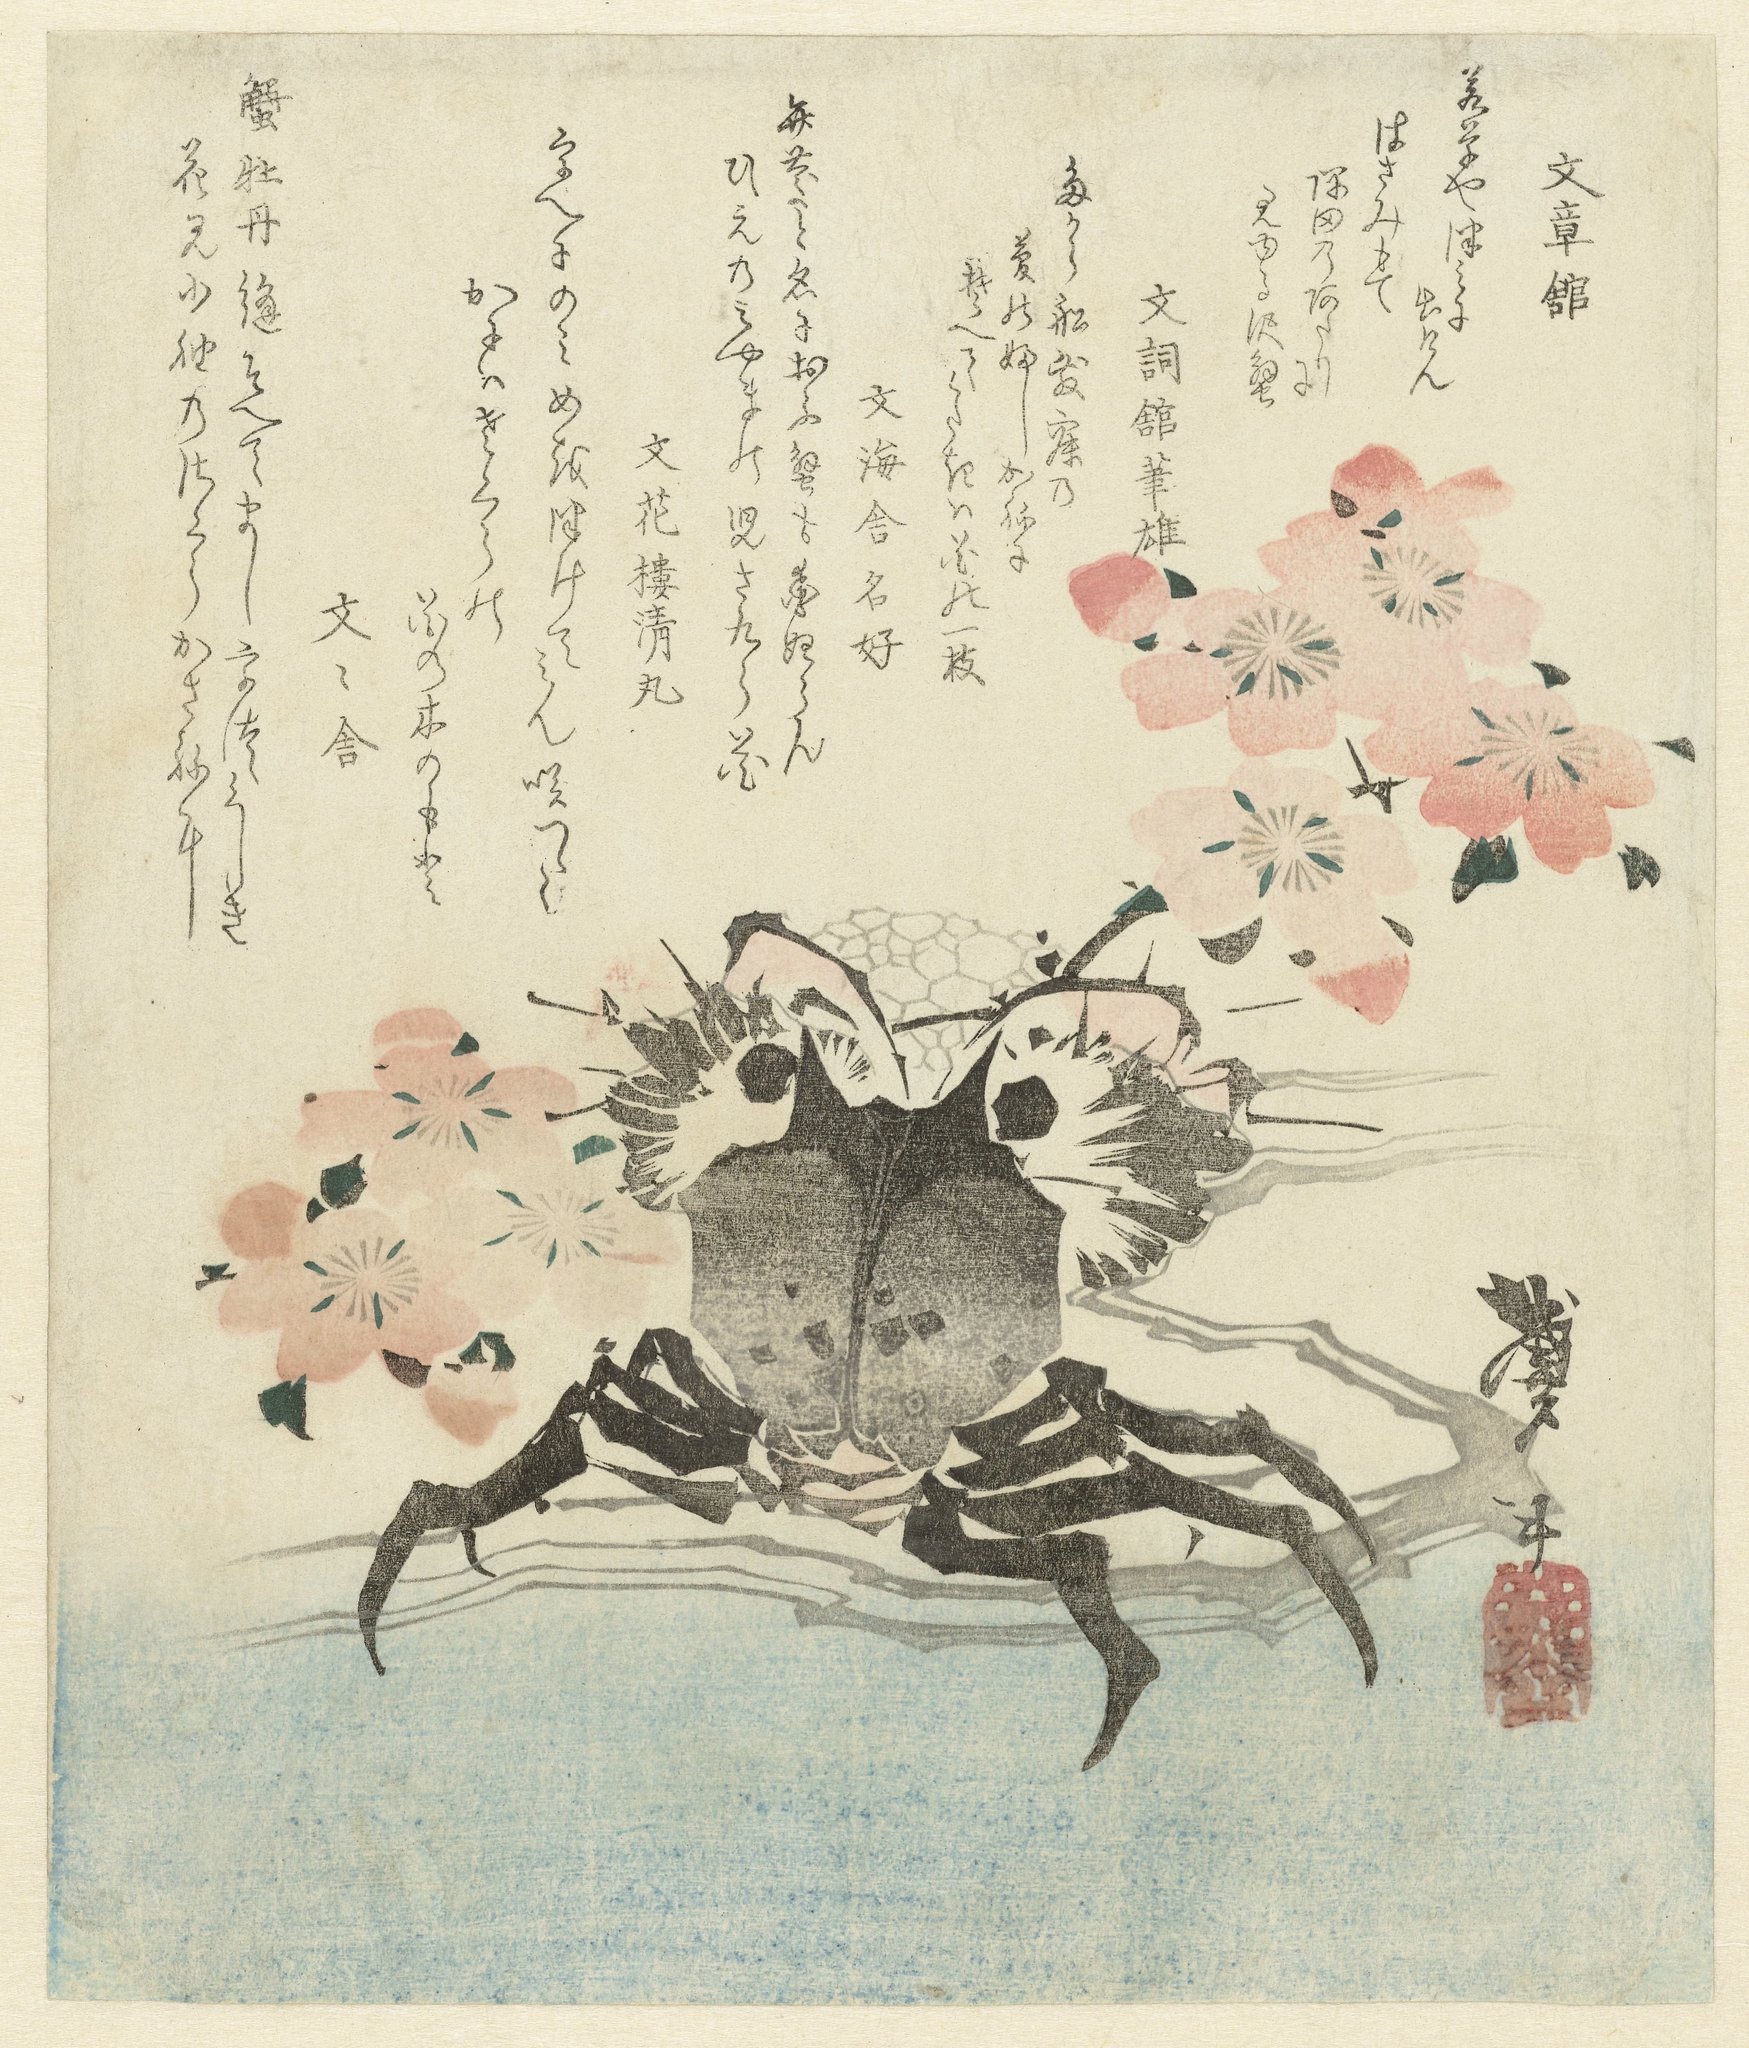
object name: surimono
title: Krab met kersenbloesem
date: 1825-1830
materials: paper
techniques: blind stamped, woodcut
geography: japan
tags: plants; vegetation (+ flowers, blossom, blossoming), crustaceans: crab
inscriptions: collector's mark, verso, stamped: Lugt 2228, collector's mark, verso, stamped: Lugt 2760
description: Een surimono is een luxe uitgevoerde prent waarop beeld met één of meerdere gedichten gecombineerd is. Bij het drukken van een surimono werd vaak gebruik gemaakt van dikker papier, blinddruk en metaal pigmenten, zoals koper- en zilverpoeder. De prenten werden vaak in opdracht van dichters gemaakt en als exclusief geschenk aan vrienden en relaties gegeven.